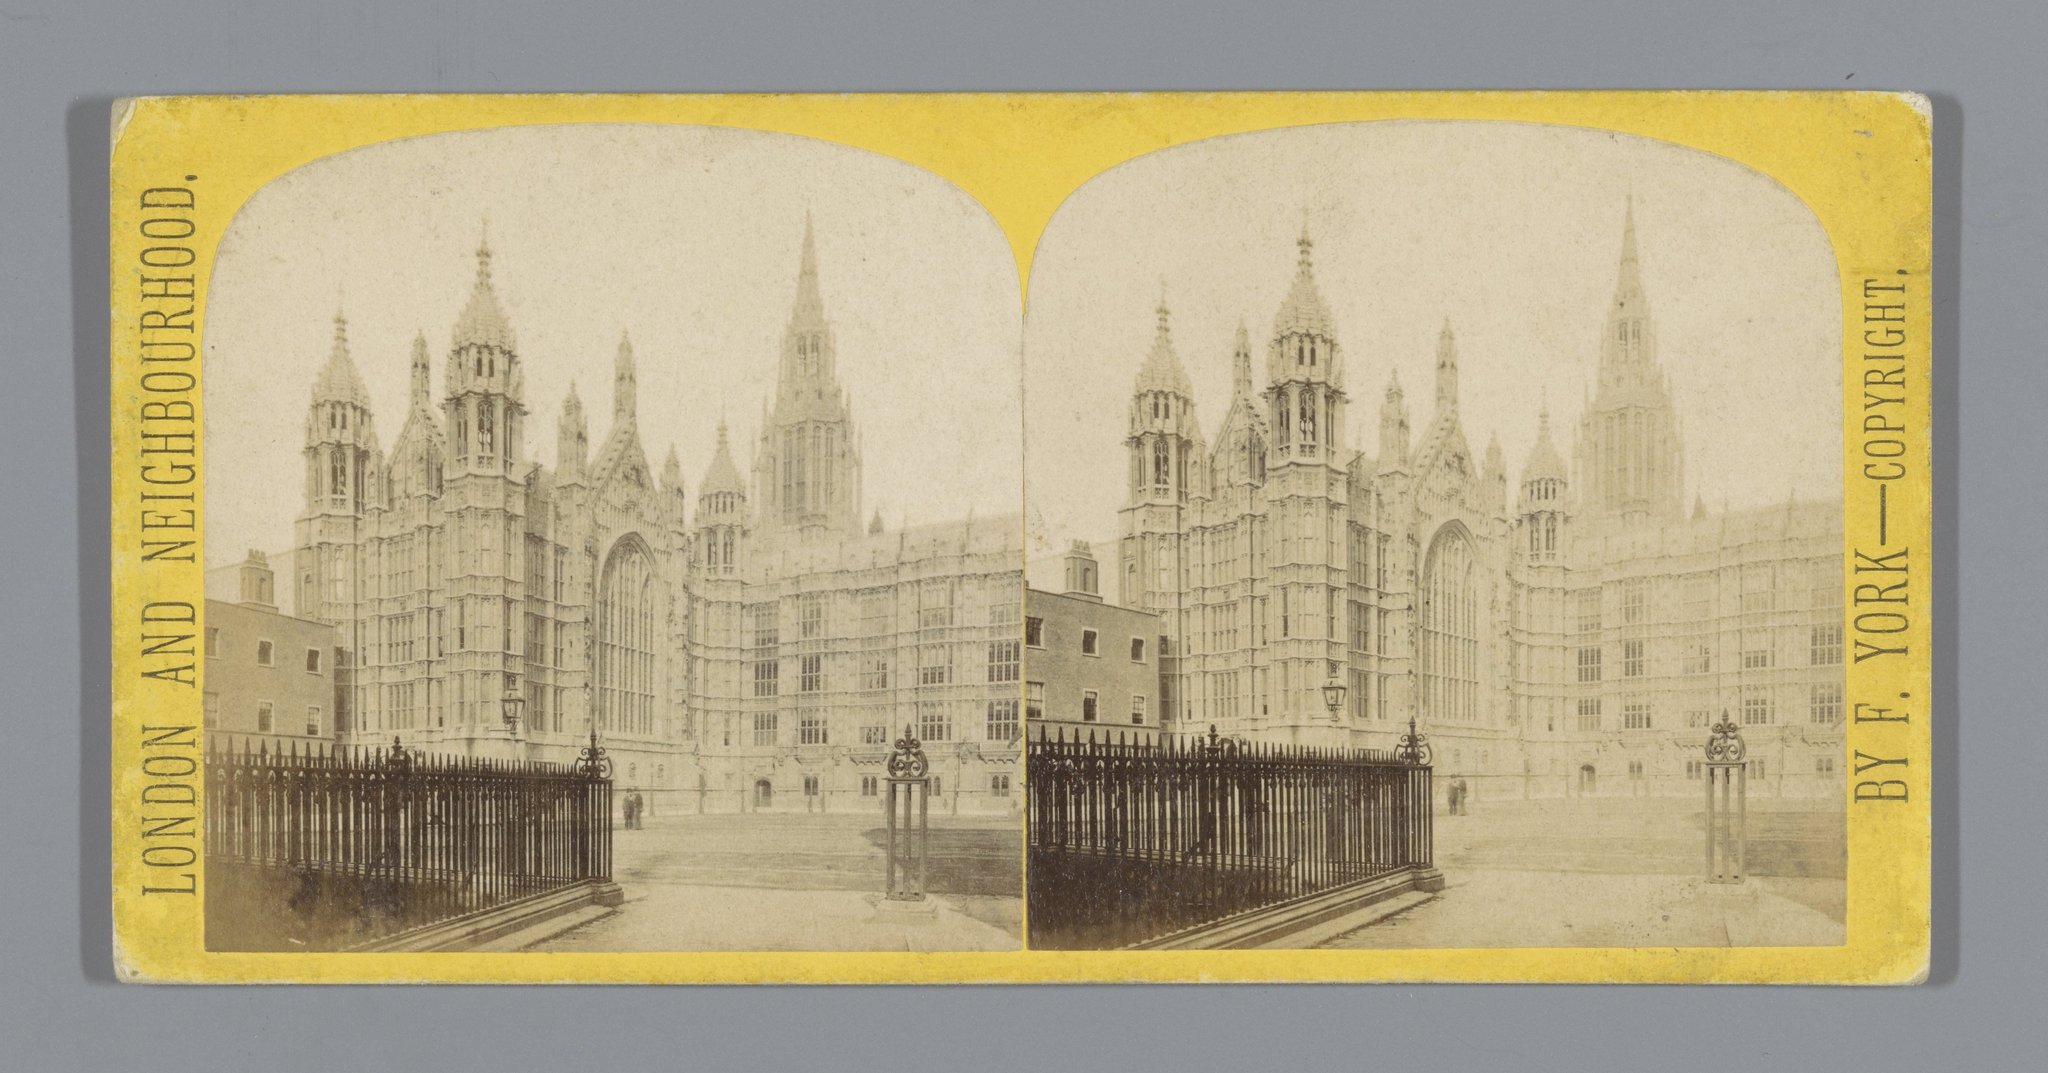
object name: stereograph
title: Houses of Parliament from Poet's Corner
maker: frederick york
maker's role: fotograaf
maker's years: 1823-1903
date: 1860-1880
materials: cardboard, photographic support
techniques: albumen print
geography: london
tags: palace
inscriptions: number: ‘7.’